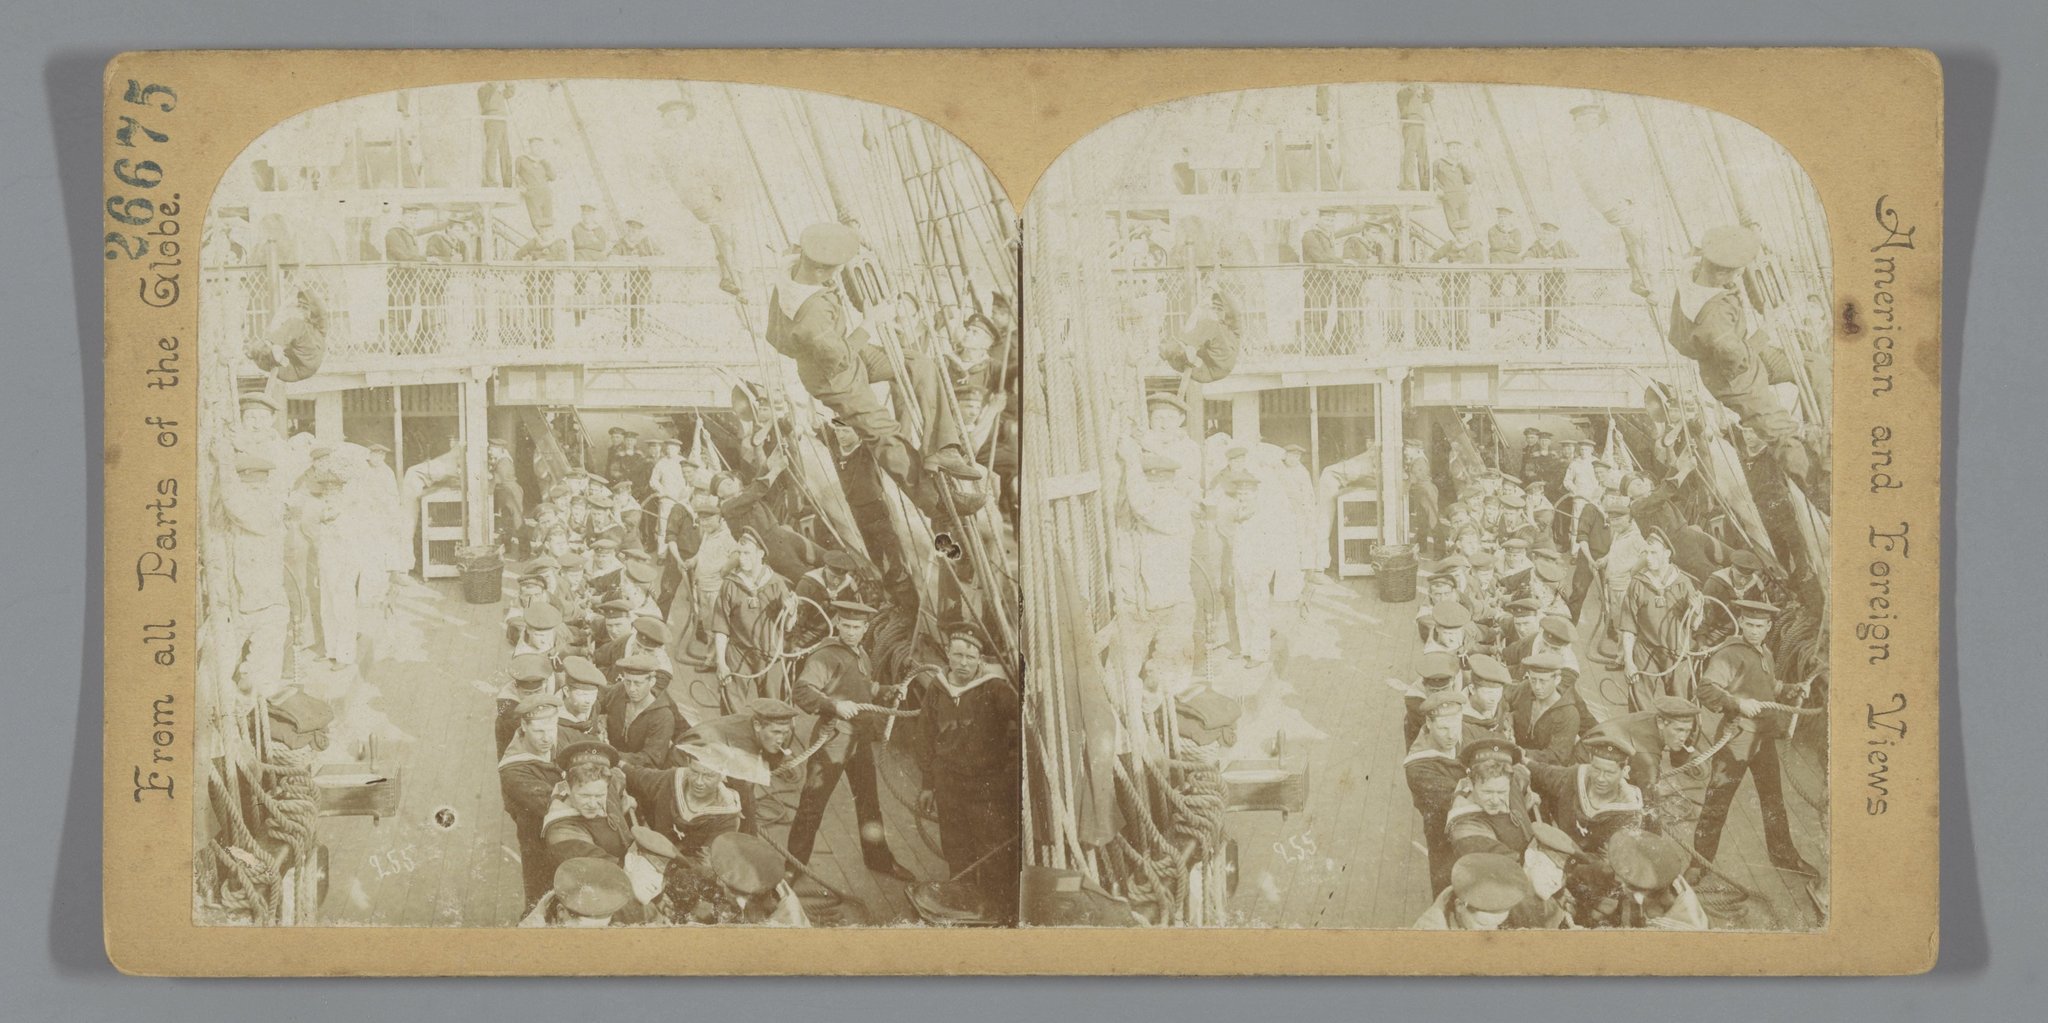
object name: stereograph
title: Matrozen hijsen de zeilen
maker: Anonymous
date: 1885-1920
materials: cardboard, paper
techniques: albumen print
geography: united states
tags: crew ~ ship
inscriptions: number: ‘26675’